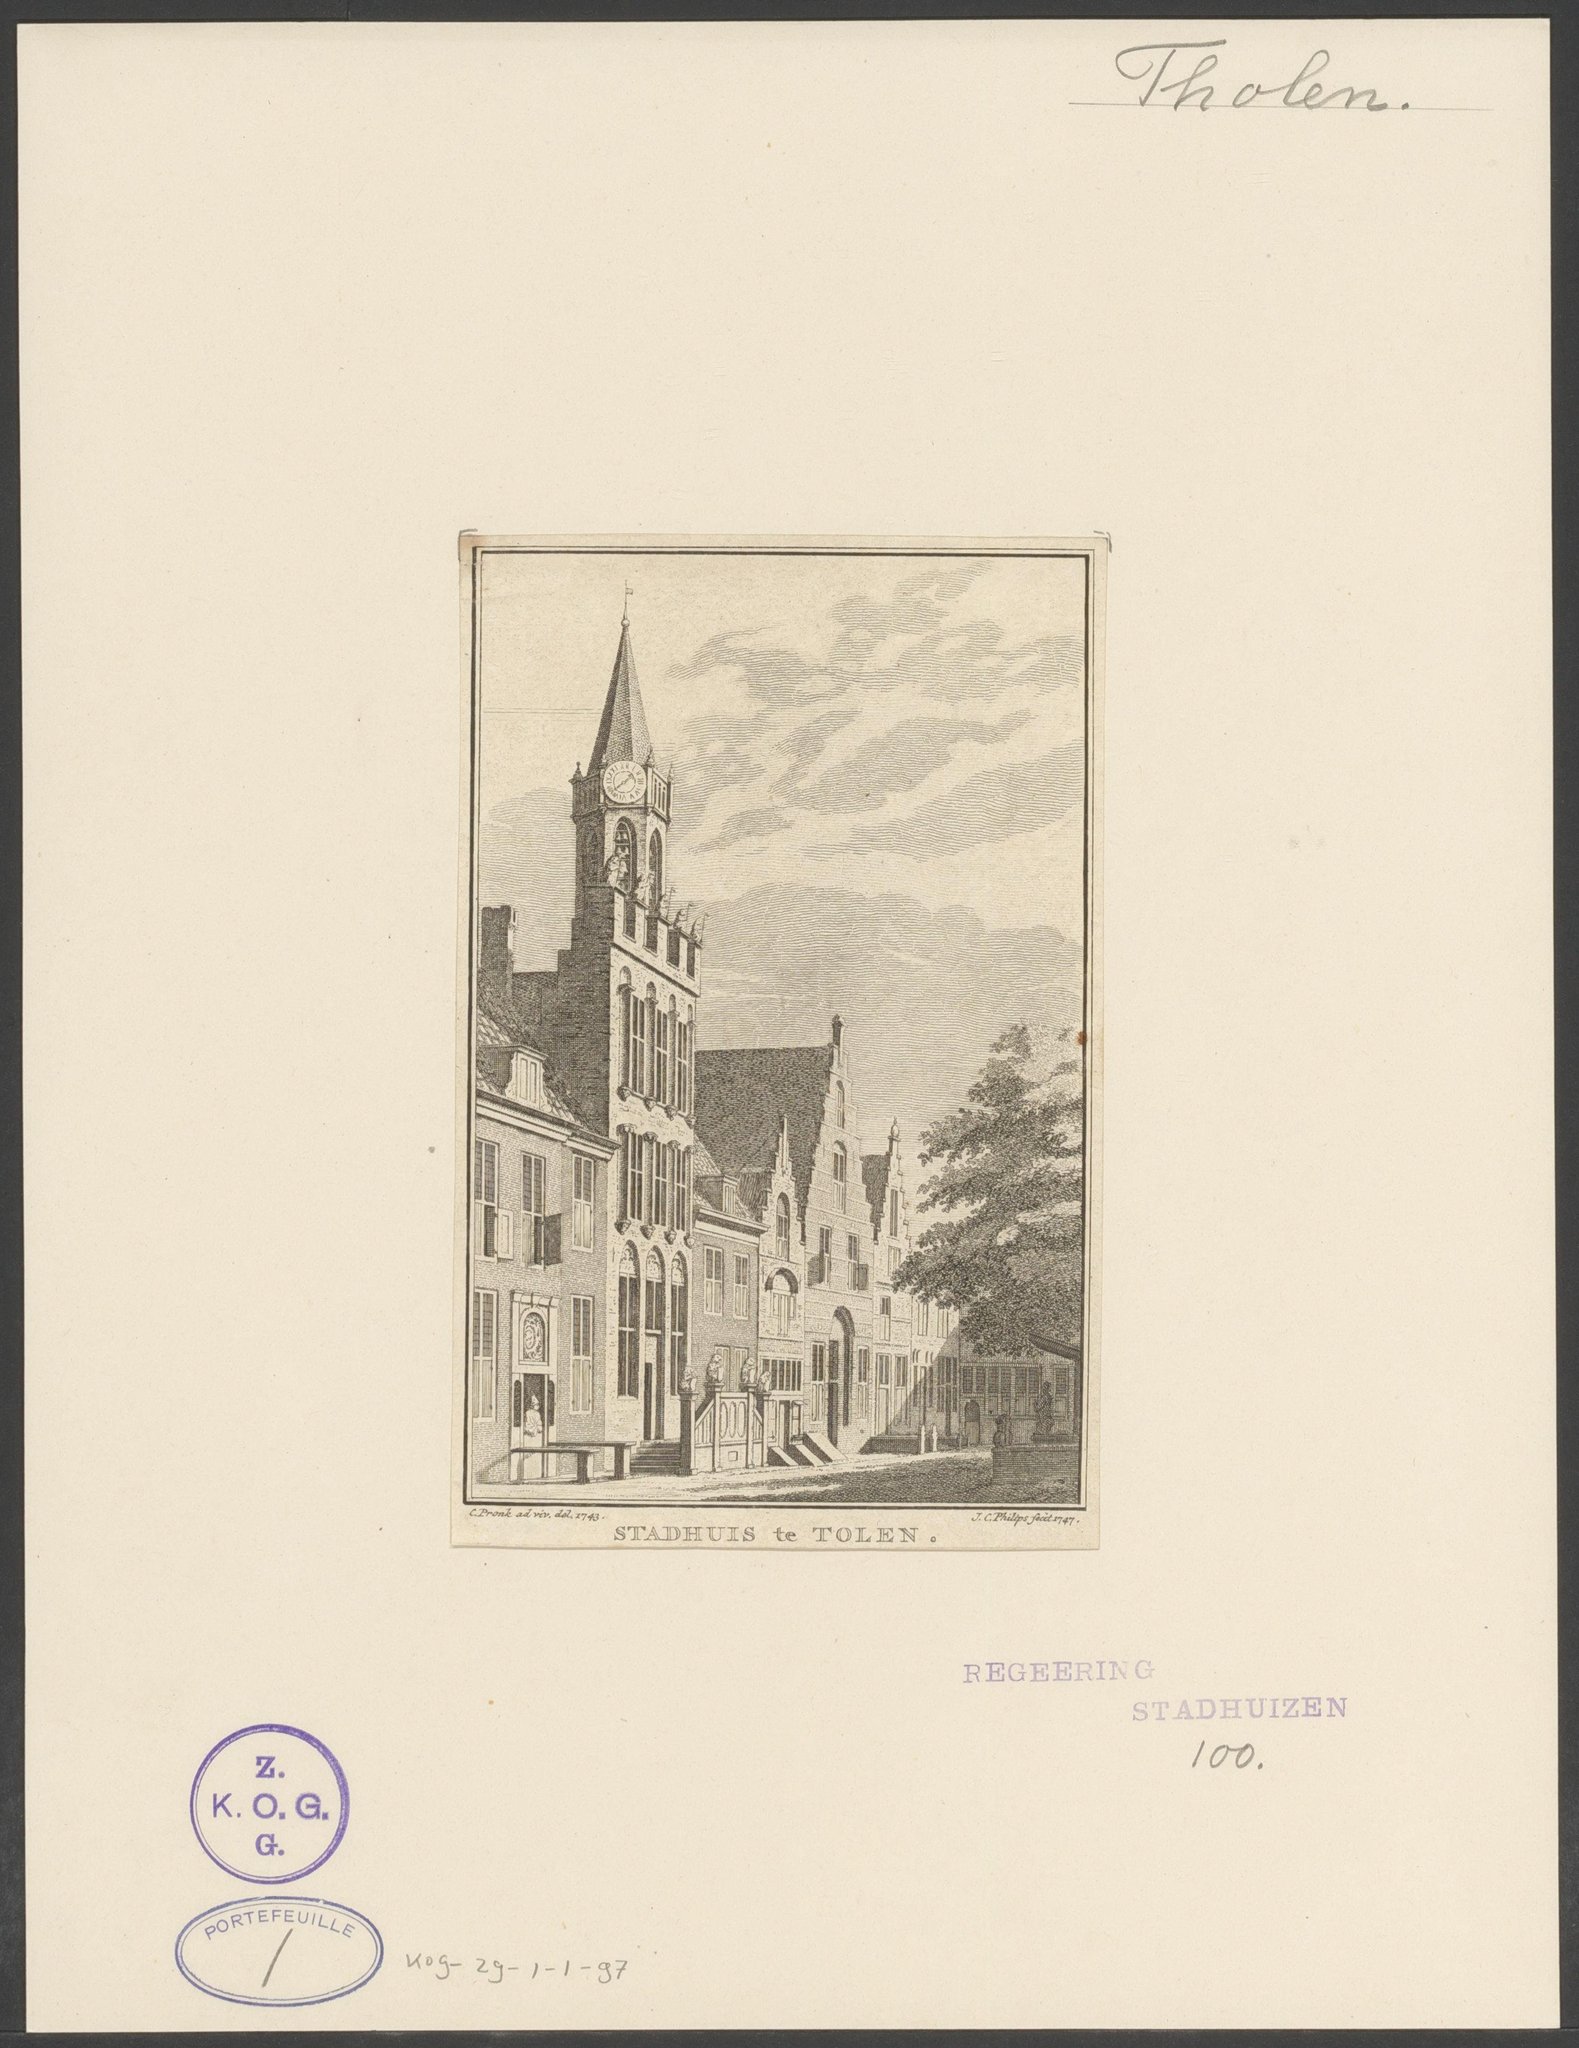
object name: print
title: Stadhuis te Tolen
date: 1747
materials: paper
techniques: etching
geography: tholen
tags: townhall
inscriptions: collector's mark, collector's mark: Lugt 1641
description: Gezicht op het stadhuis van Tholen, in de situatie omstreeks 1743. Onderwerpsrubrieken binnen de Atlas Zeden en Gewoonten: Regeering, Stadhuizen (O-T).